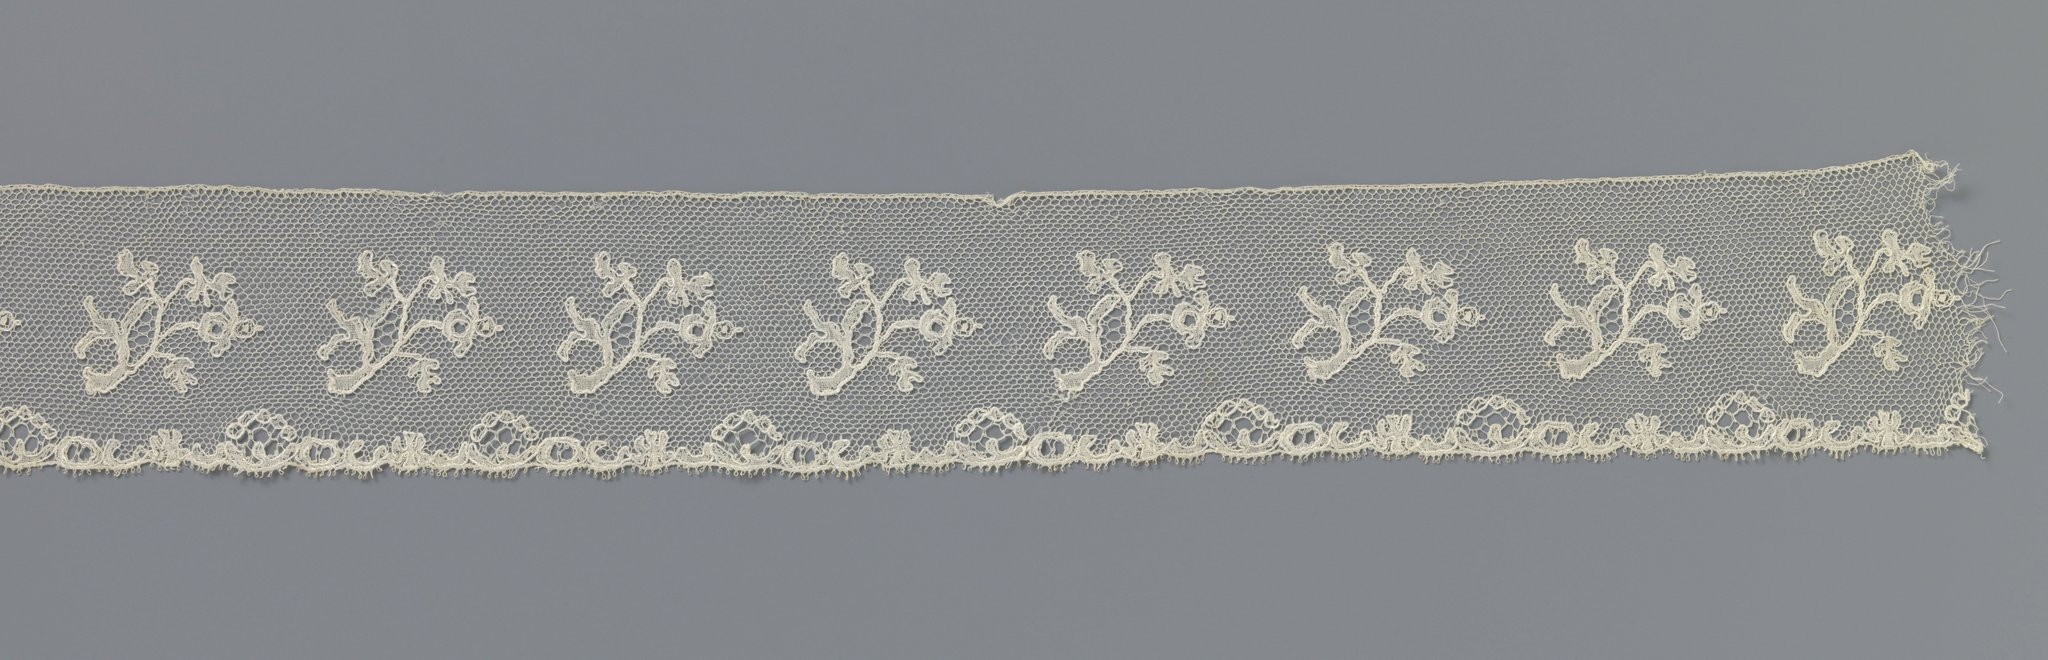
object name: strip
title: Strook kloskant met losse s-vormige takken op de middenlijn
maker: Anonymous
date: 1800-1824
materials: linen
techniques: lace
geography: lille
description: Strook naturelkleurige kloskant: Rijselse kant. Het zich herhalende patroon bestaat op de middenlijn uit losse s-vormige takken, met blaadjes en één rond bloempje bekroond door twee blaadjes en een cirkeltje. Langs de onderzijde van de strook wordt een doorlopend patroon gevormd door een aaneenschakeling van blaadjes, boogjes, en opengewerkte ovalen, waarvan er één wordt bekroond door een parellijstje. De motieven zijn met elkaar verbonden door een fijne traliegrond, een tulegrond. De motieven zijn gemaakt in linnenslag met enkele grote uitsparingen en met dikkere, glimmende contourdraden. In de ovalen langs de onderzijde en in een spitsovaalvormige ruimte tussen een blad en de s-vormige tak zijn siergronden toegepast. De cirkeltjes op de bloempjes zijn versierd met één moesje, gemaakt in vormslag, verwerkt in een spaarzaam stukje siergrond. De bovenzijde van de strook is recht afgewerkt. De zeer flauw geschulpte onderzijde is afgewerkt met picots.